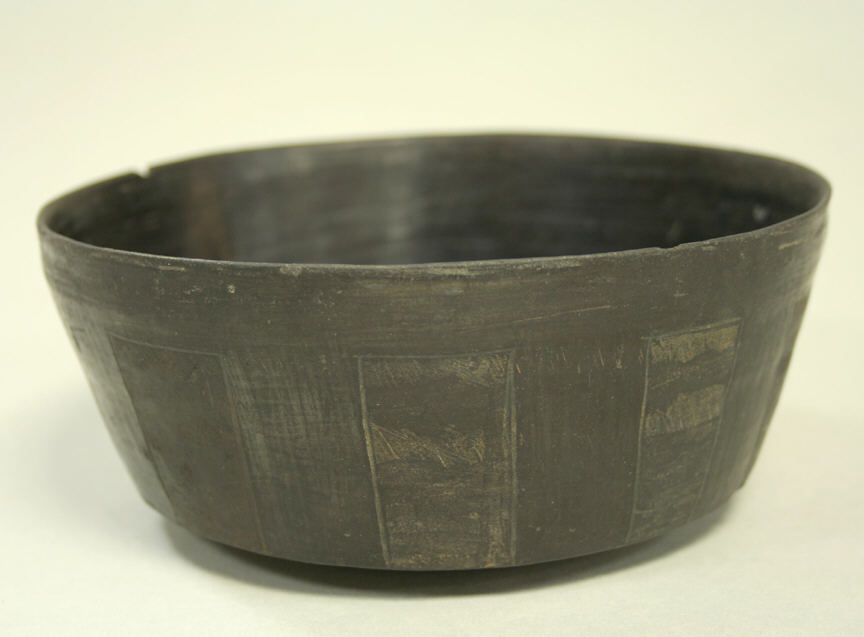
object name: bowl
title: Patterned Blackware Bowl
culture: cavernas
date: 500-301 BCE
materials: ceramic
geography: peru